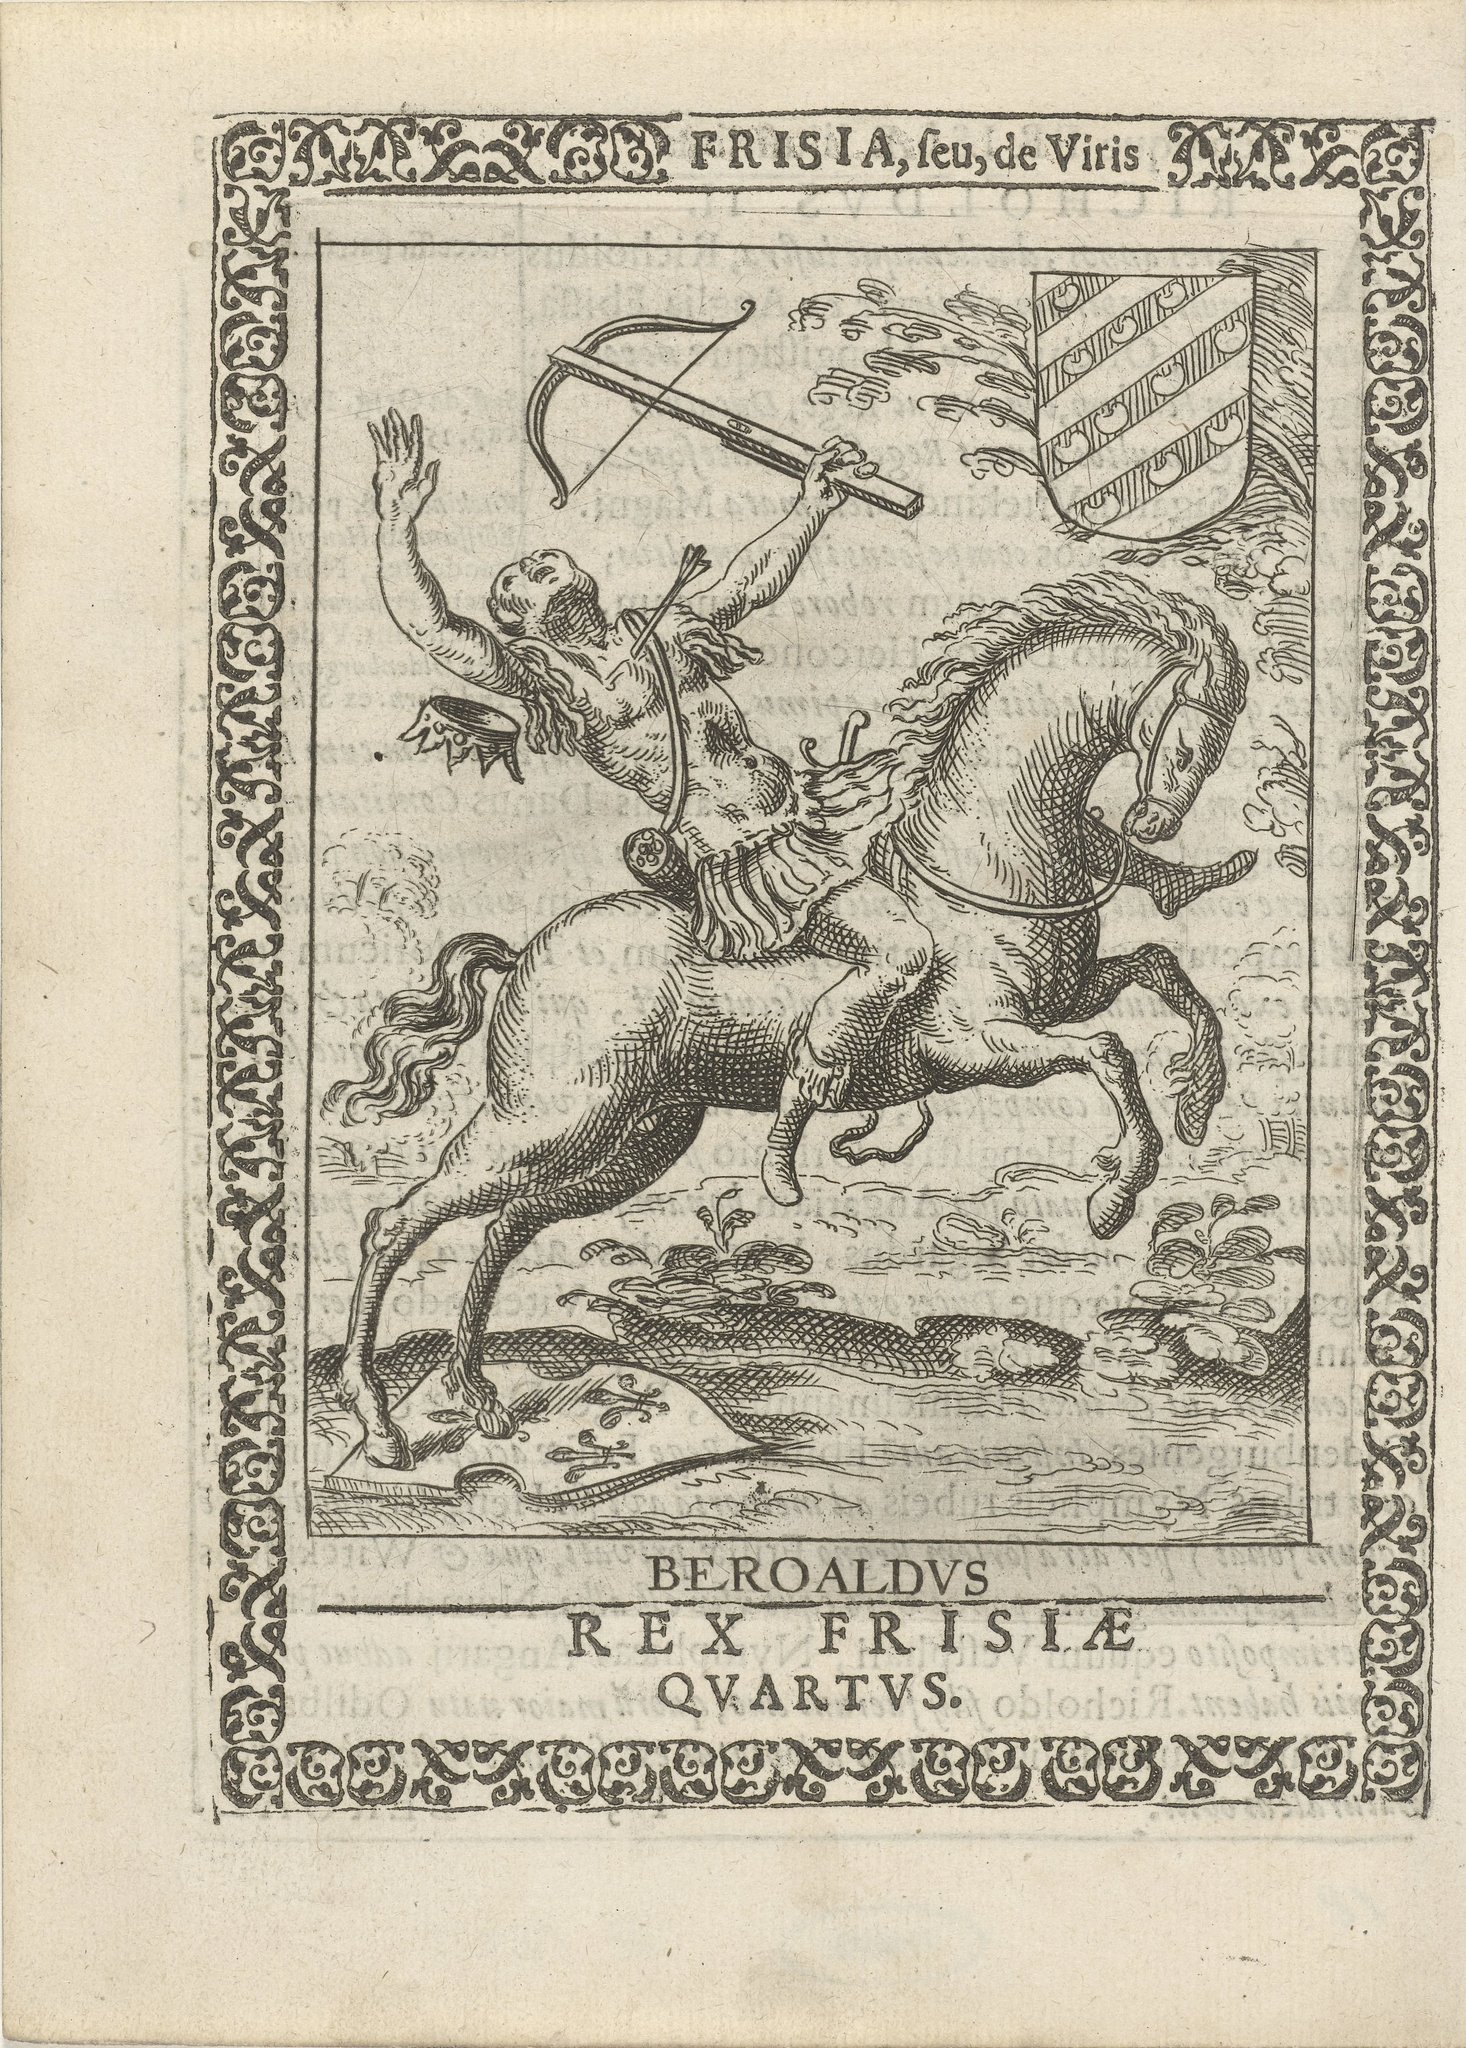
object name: print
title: Koningen en Potestaten van Friesland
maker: pieter feddes van harlingen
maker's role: painter, print maker, publisher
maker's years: 1586-1623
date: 1618-1620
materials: paper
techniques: etching, letterpress printing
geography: friesland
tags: ruler, sovereign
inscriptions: collector's mark: Lugt 2228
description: Beroald, vierde koning der Friezen. Wordt rijdend op een paard door een pijl getroffen. In een ornamentale omlijsting. Illustratie, met tekst op achterzijde, afkomstig uit het boek: Frisia seu de viris rebusque Frisiae illustribus libri duo.